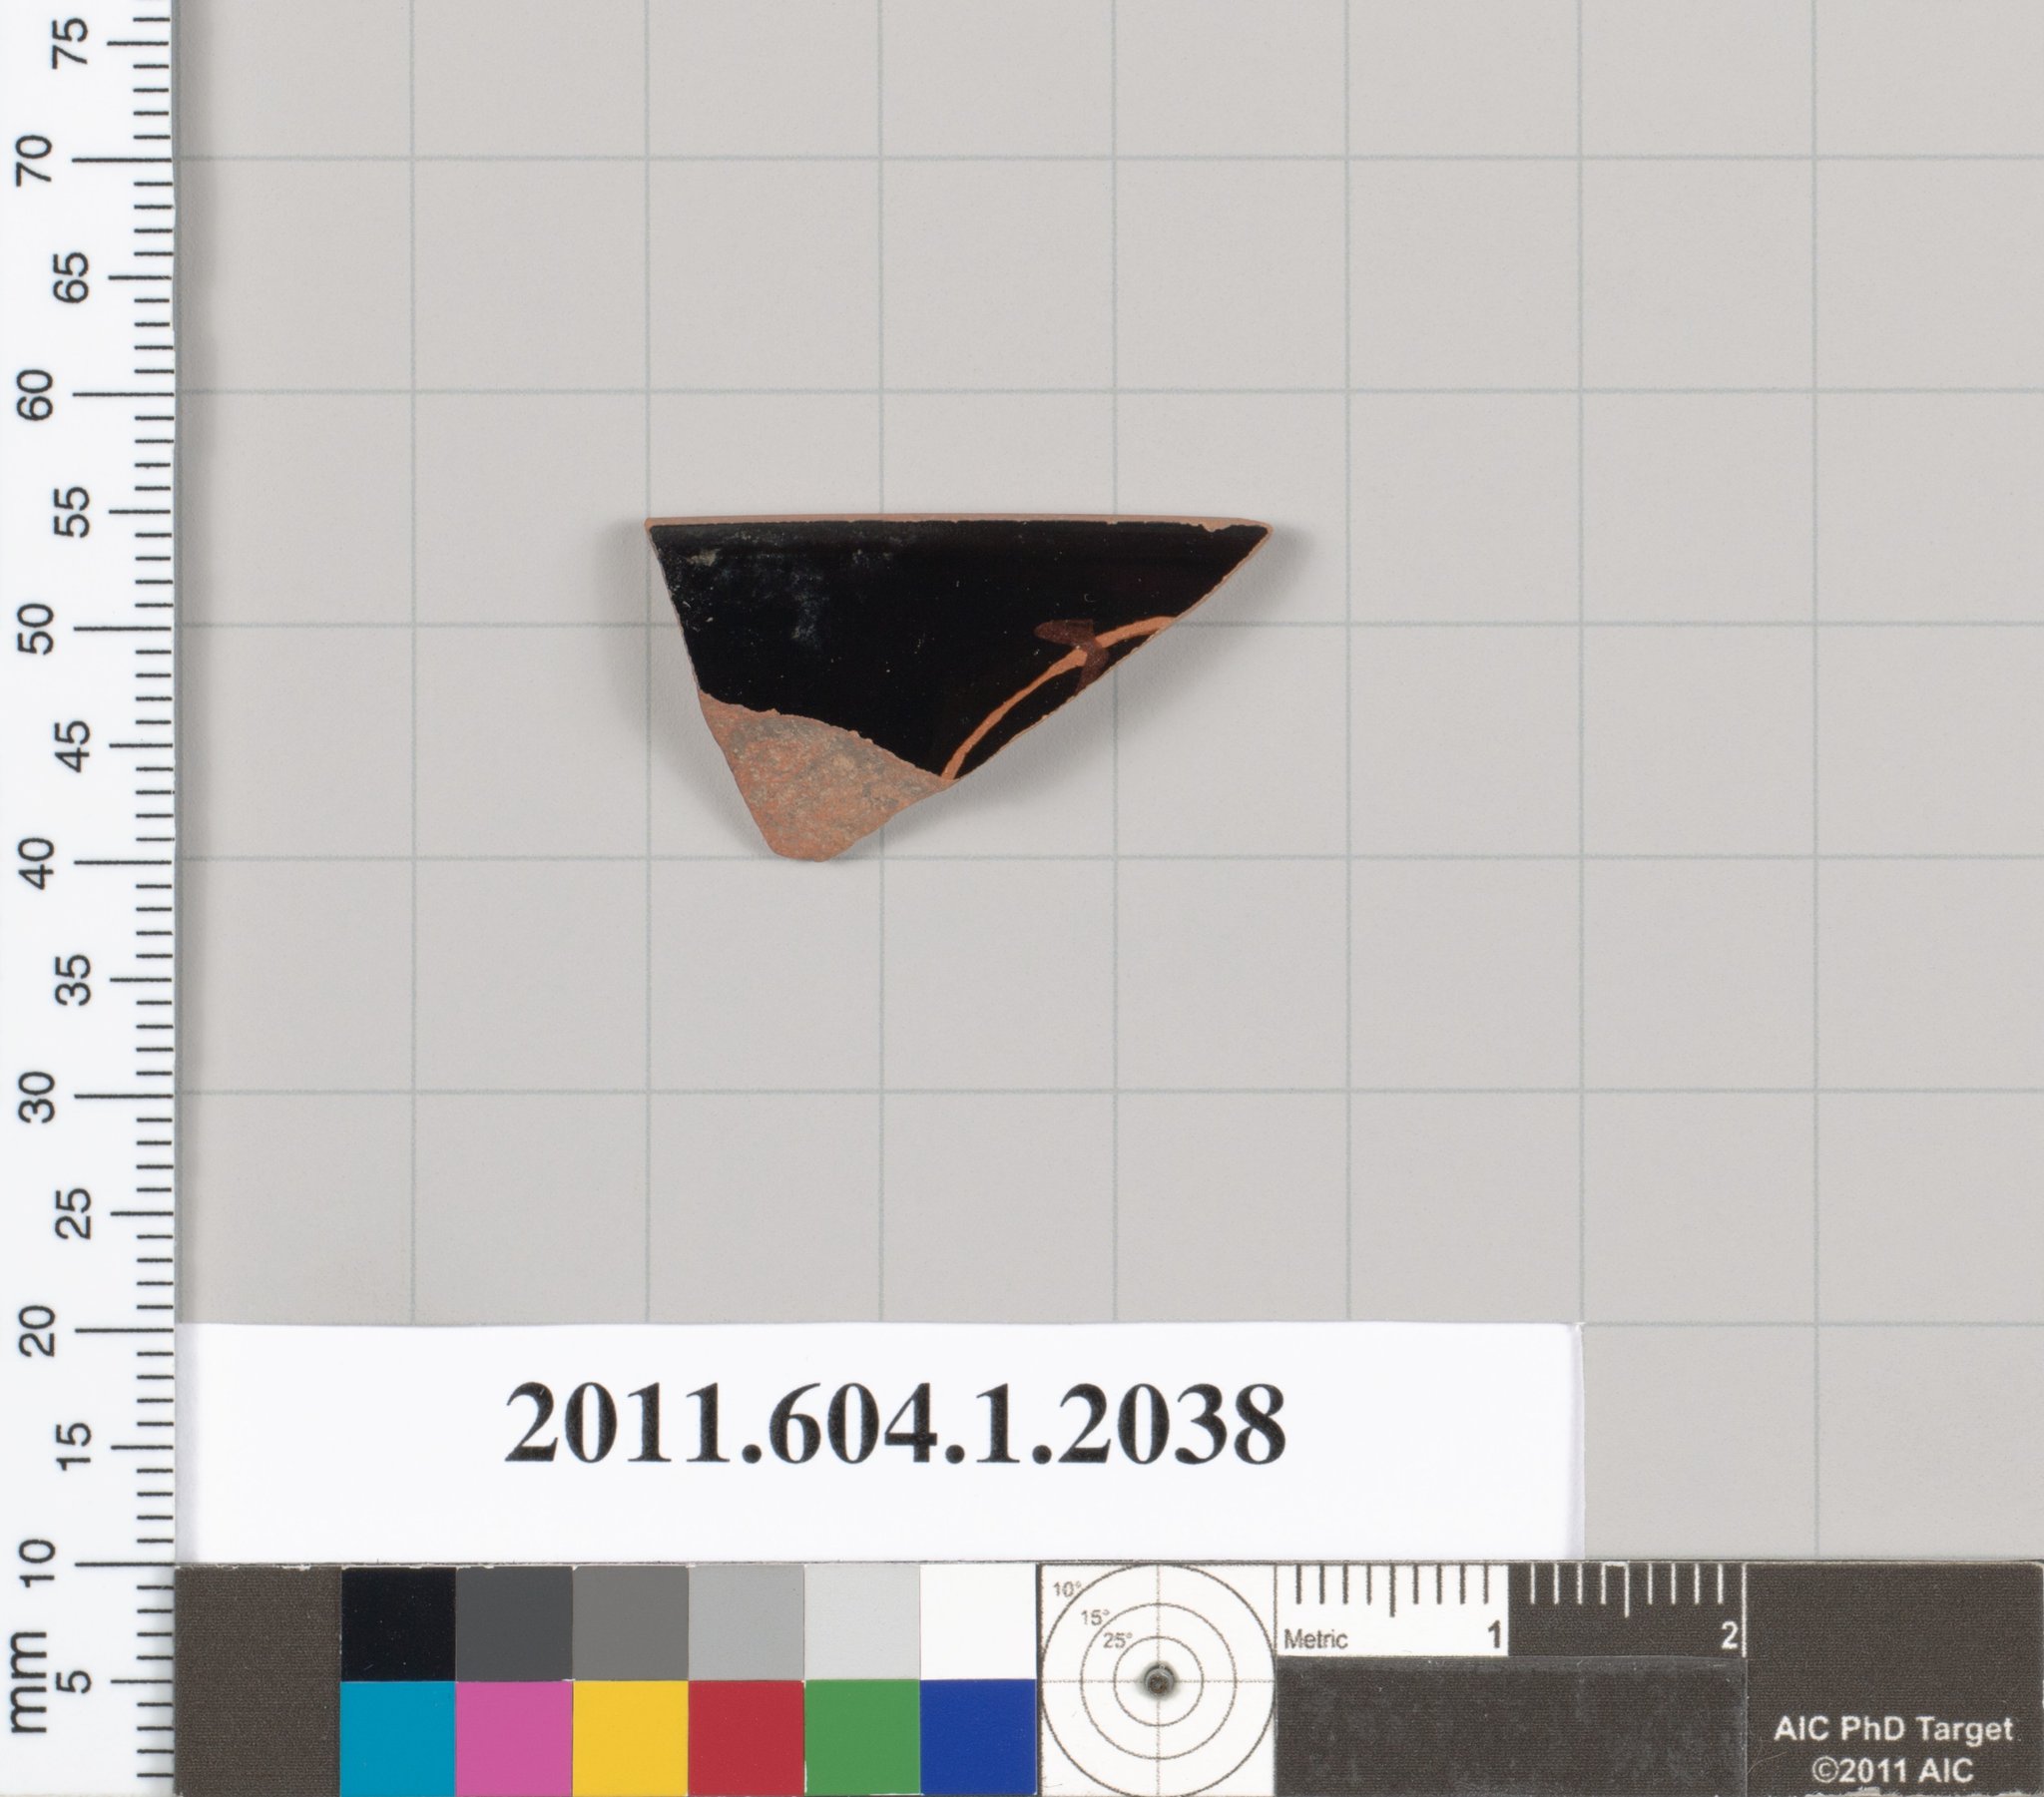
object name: kylix fragment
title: Terracotta rim fragment of a kylix (drinking cup)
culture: greek, attic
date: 500-401 BCE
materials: terracotta